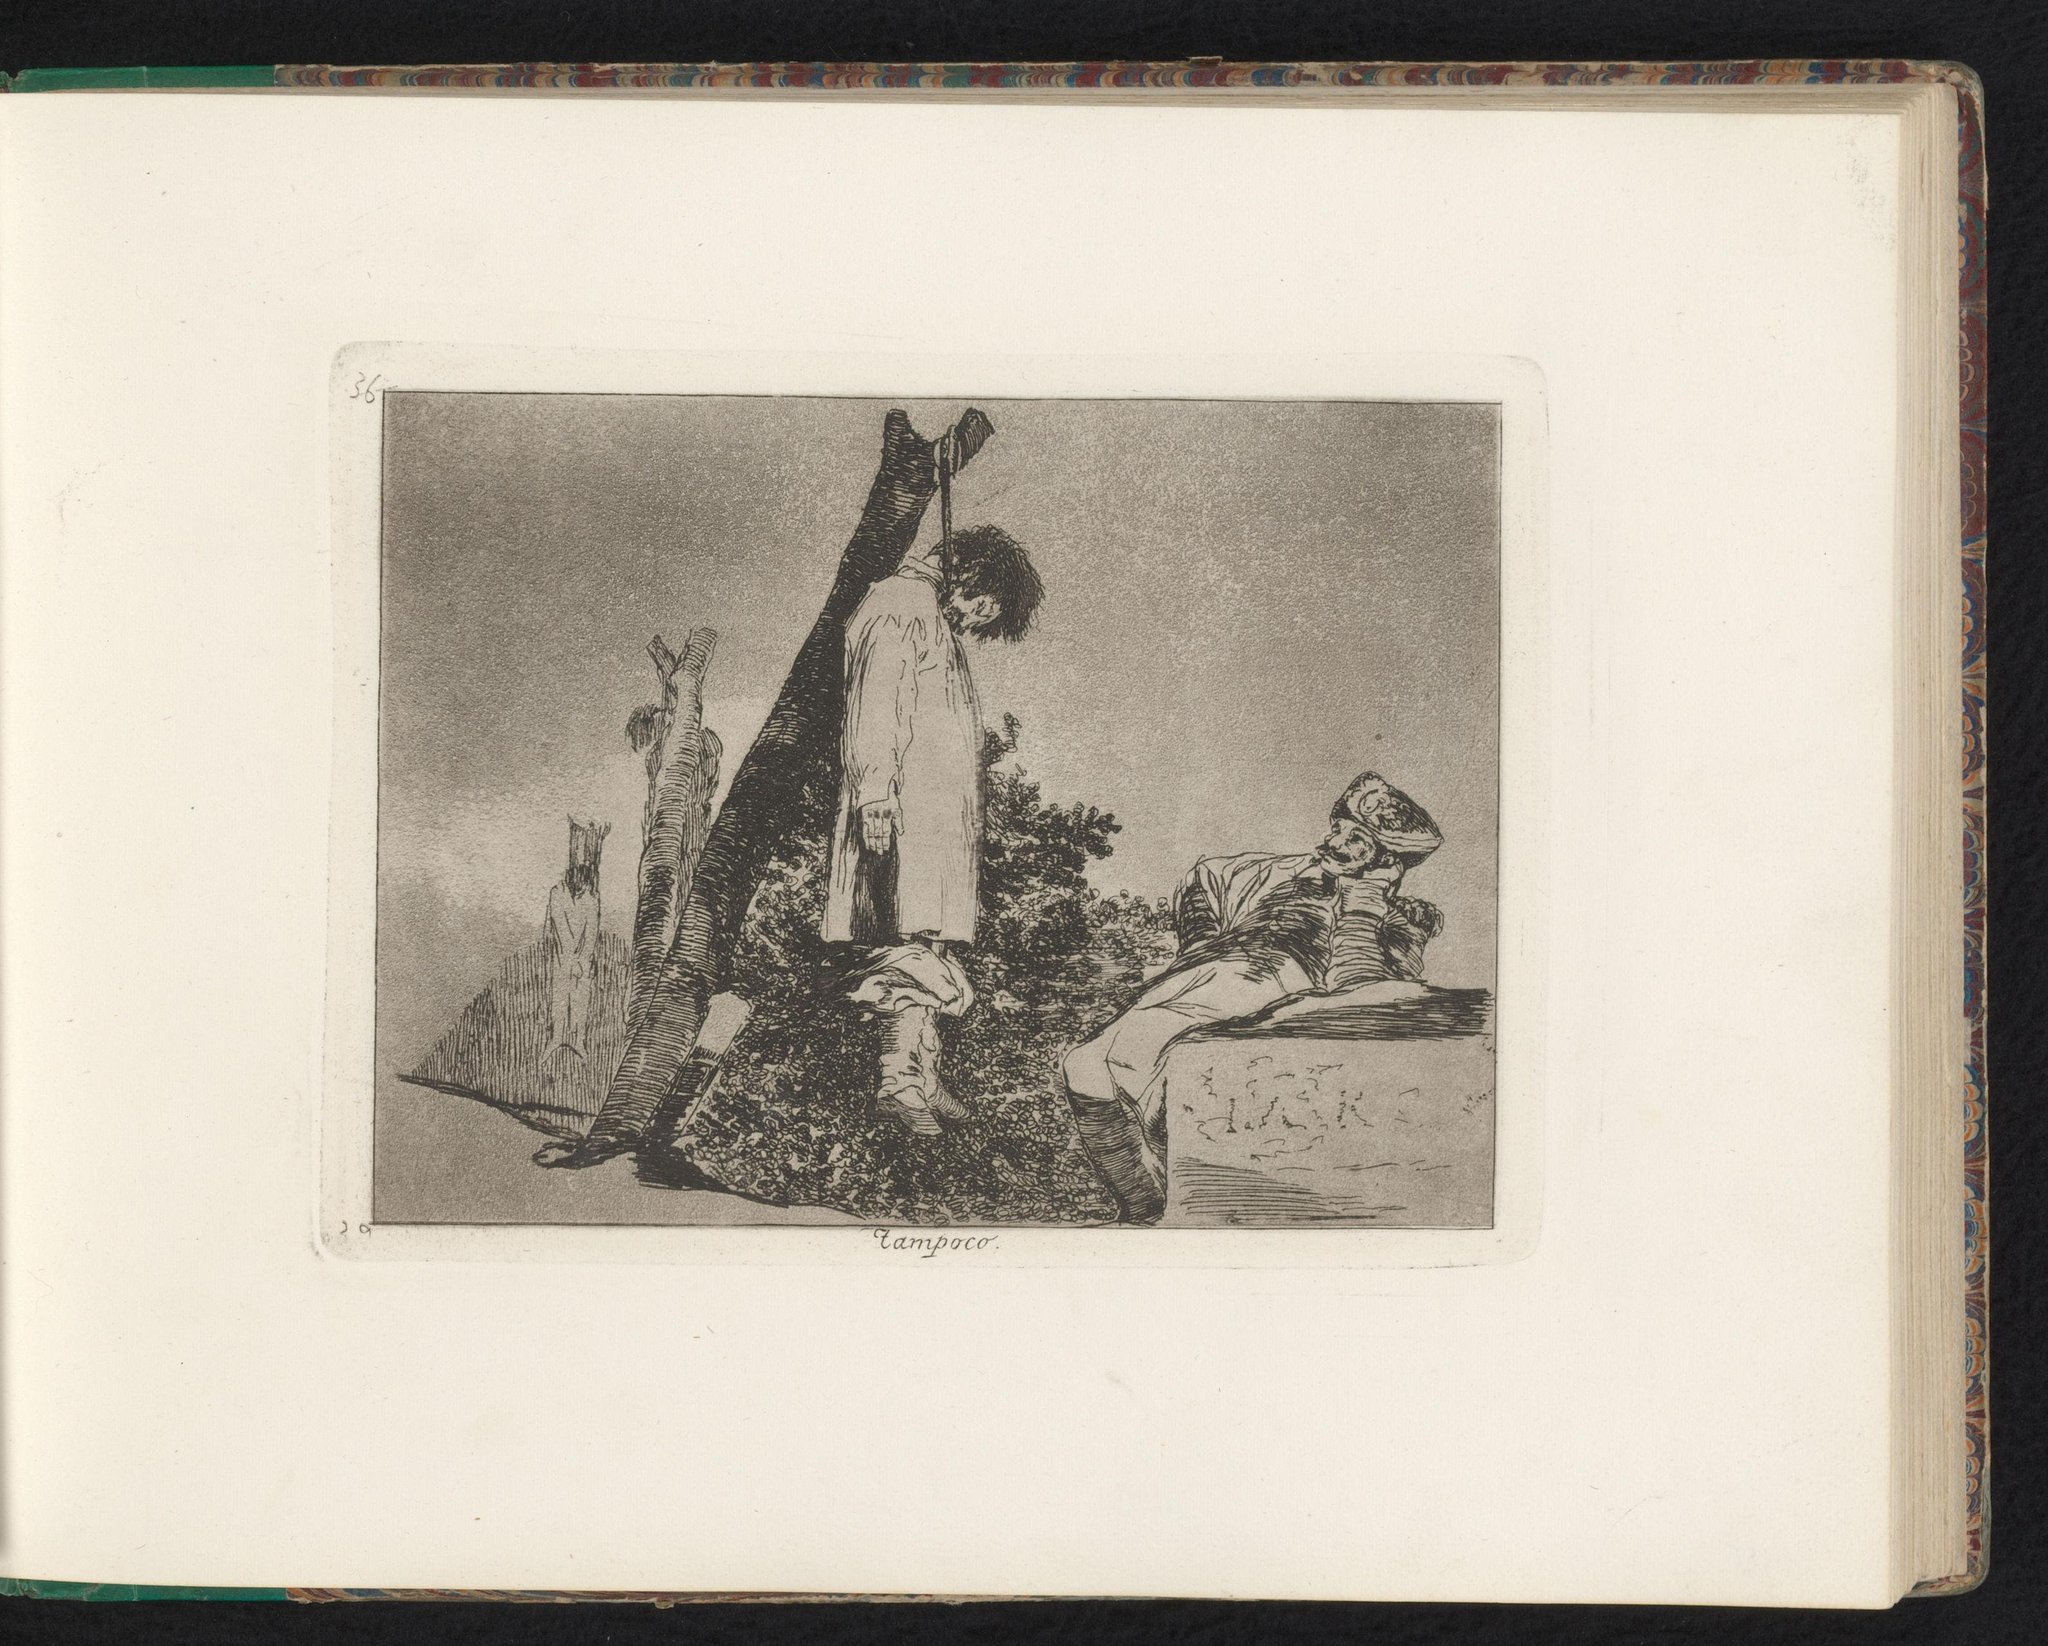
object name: print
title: Soldaat rust uit naast een gehangene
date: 1810-1820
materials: paper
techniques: aquatint, drypoint, engraving, etching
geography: madrid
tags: violent death by hanging, horrors of war, spain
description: Deze prent maakt deel uit van een album.